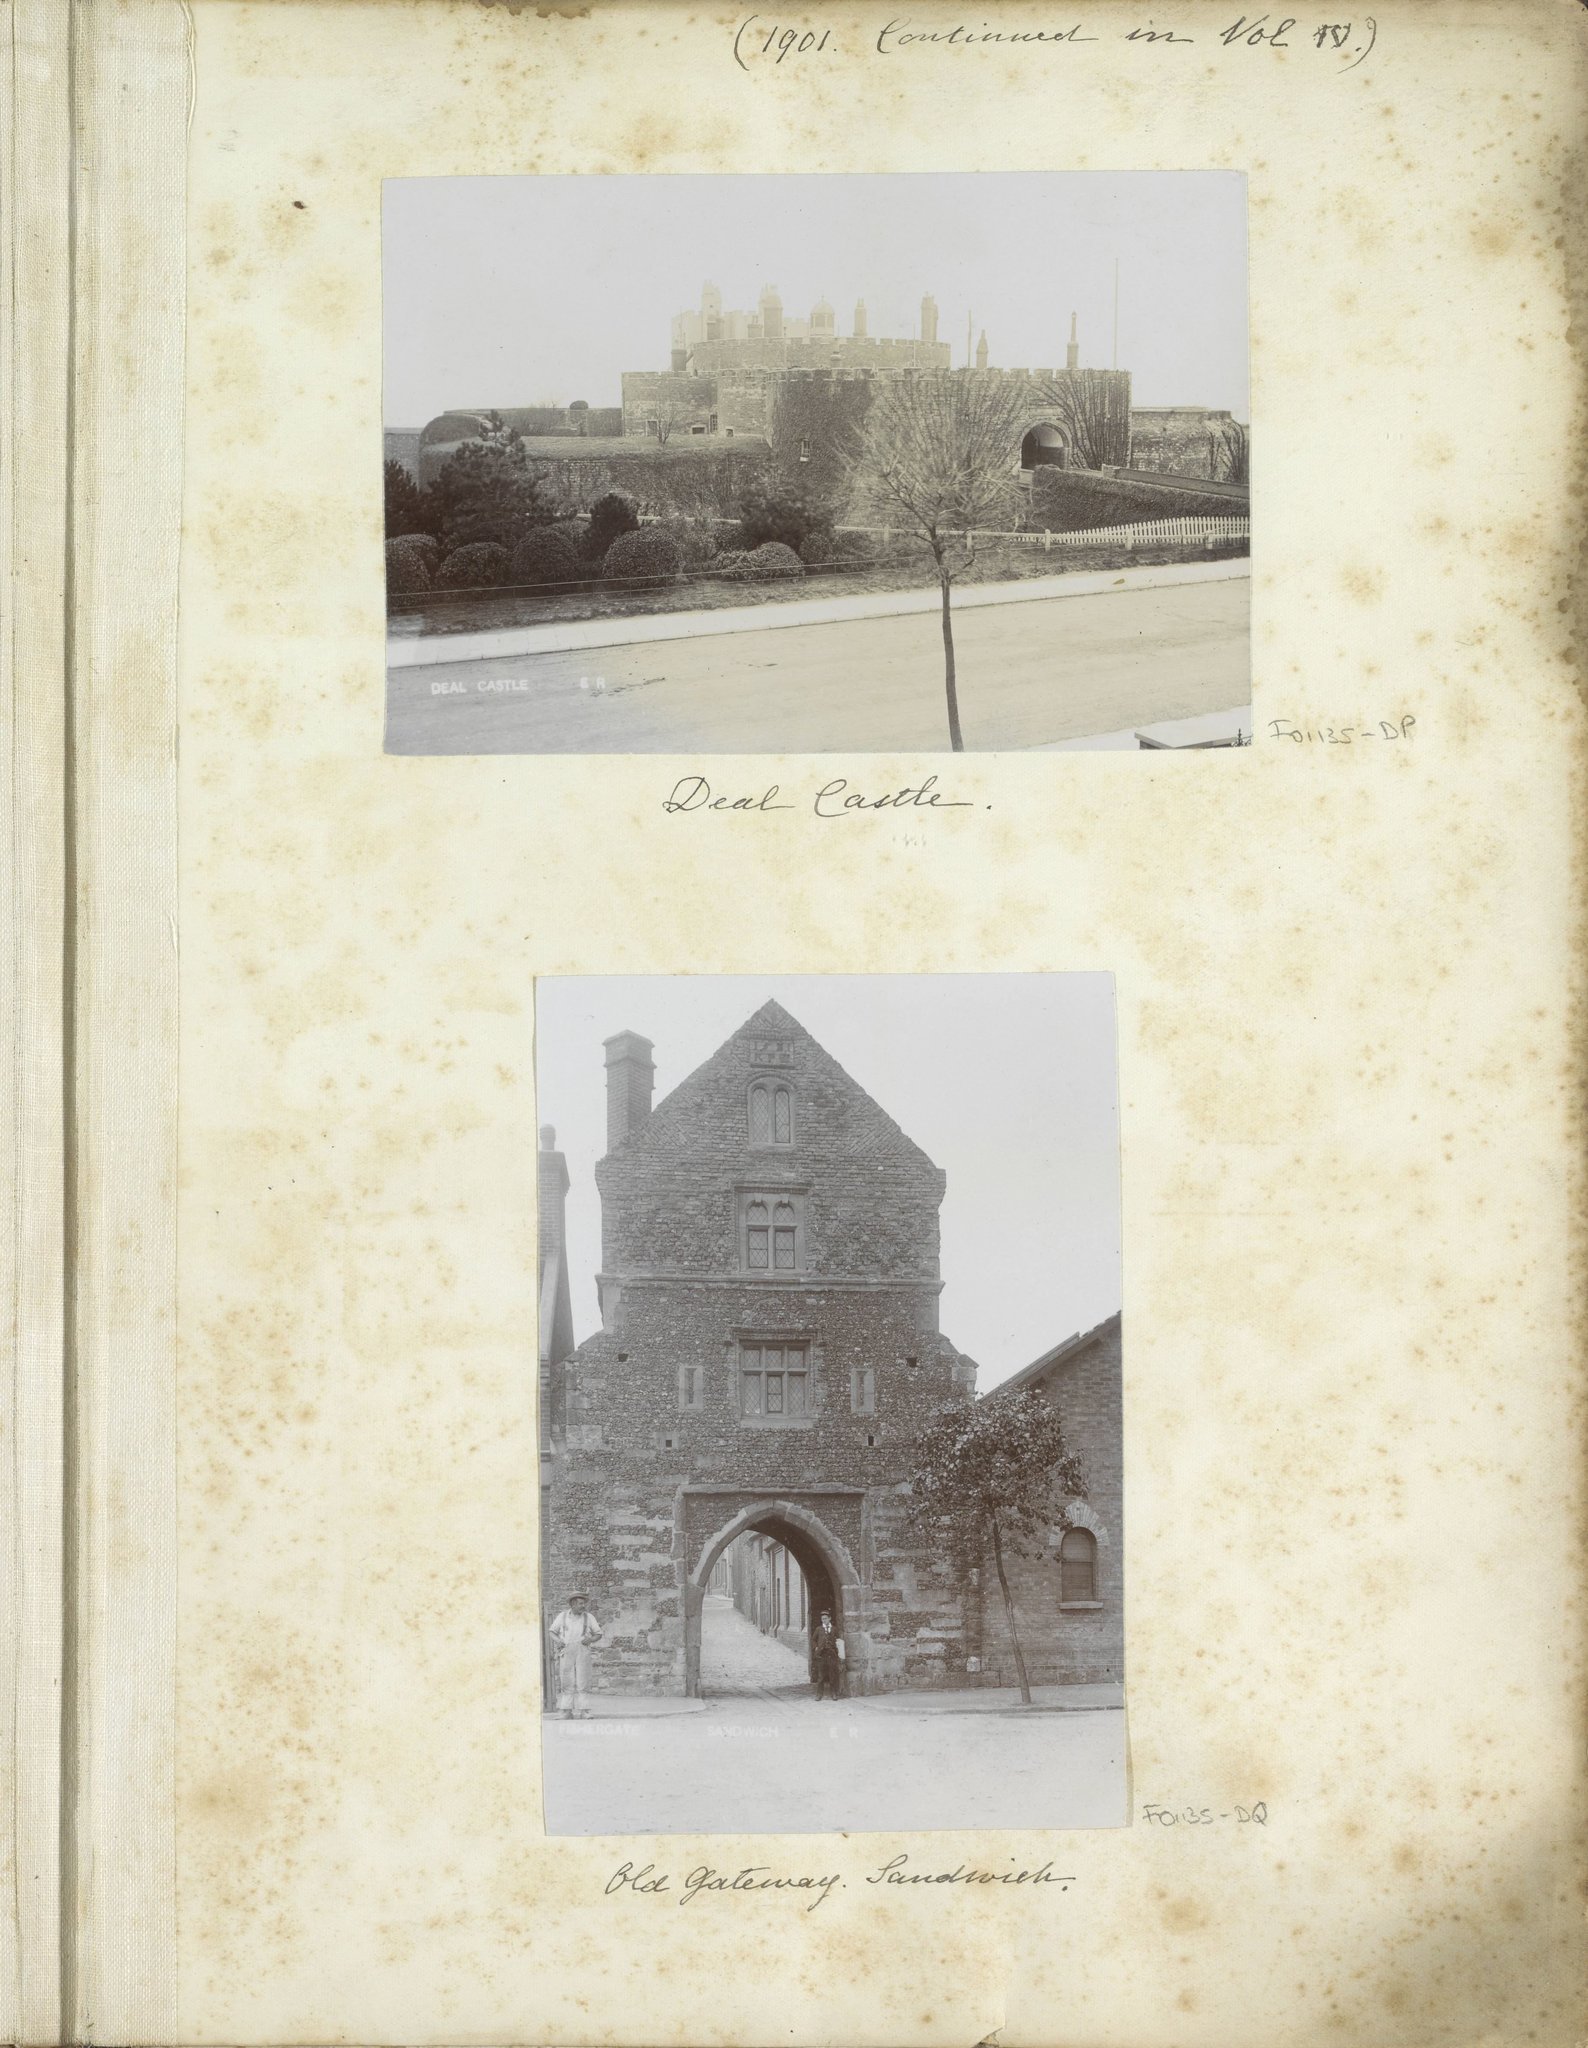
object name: photograph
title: Deal Castle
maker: Anonymous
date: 1901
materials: paper, photographic support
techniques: daylight paper print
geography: deal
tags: castle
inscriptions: name: ‘ER’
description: Onderdeel van Reisalbum met foto's van bezienswaardigheden in Engeland en Frankrijk.